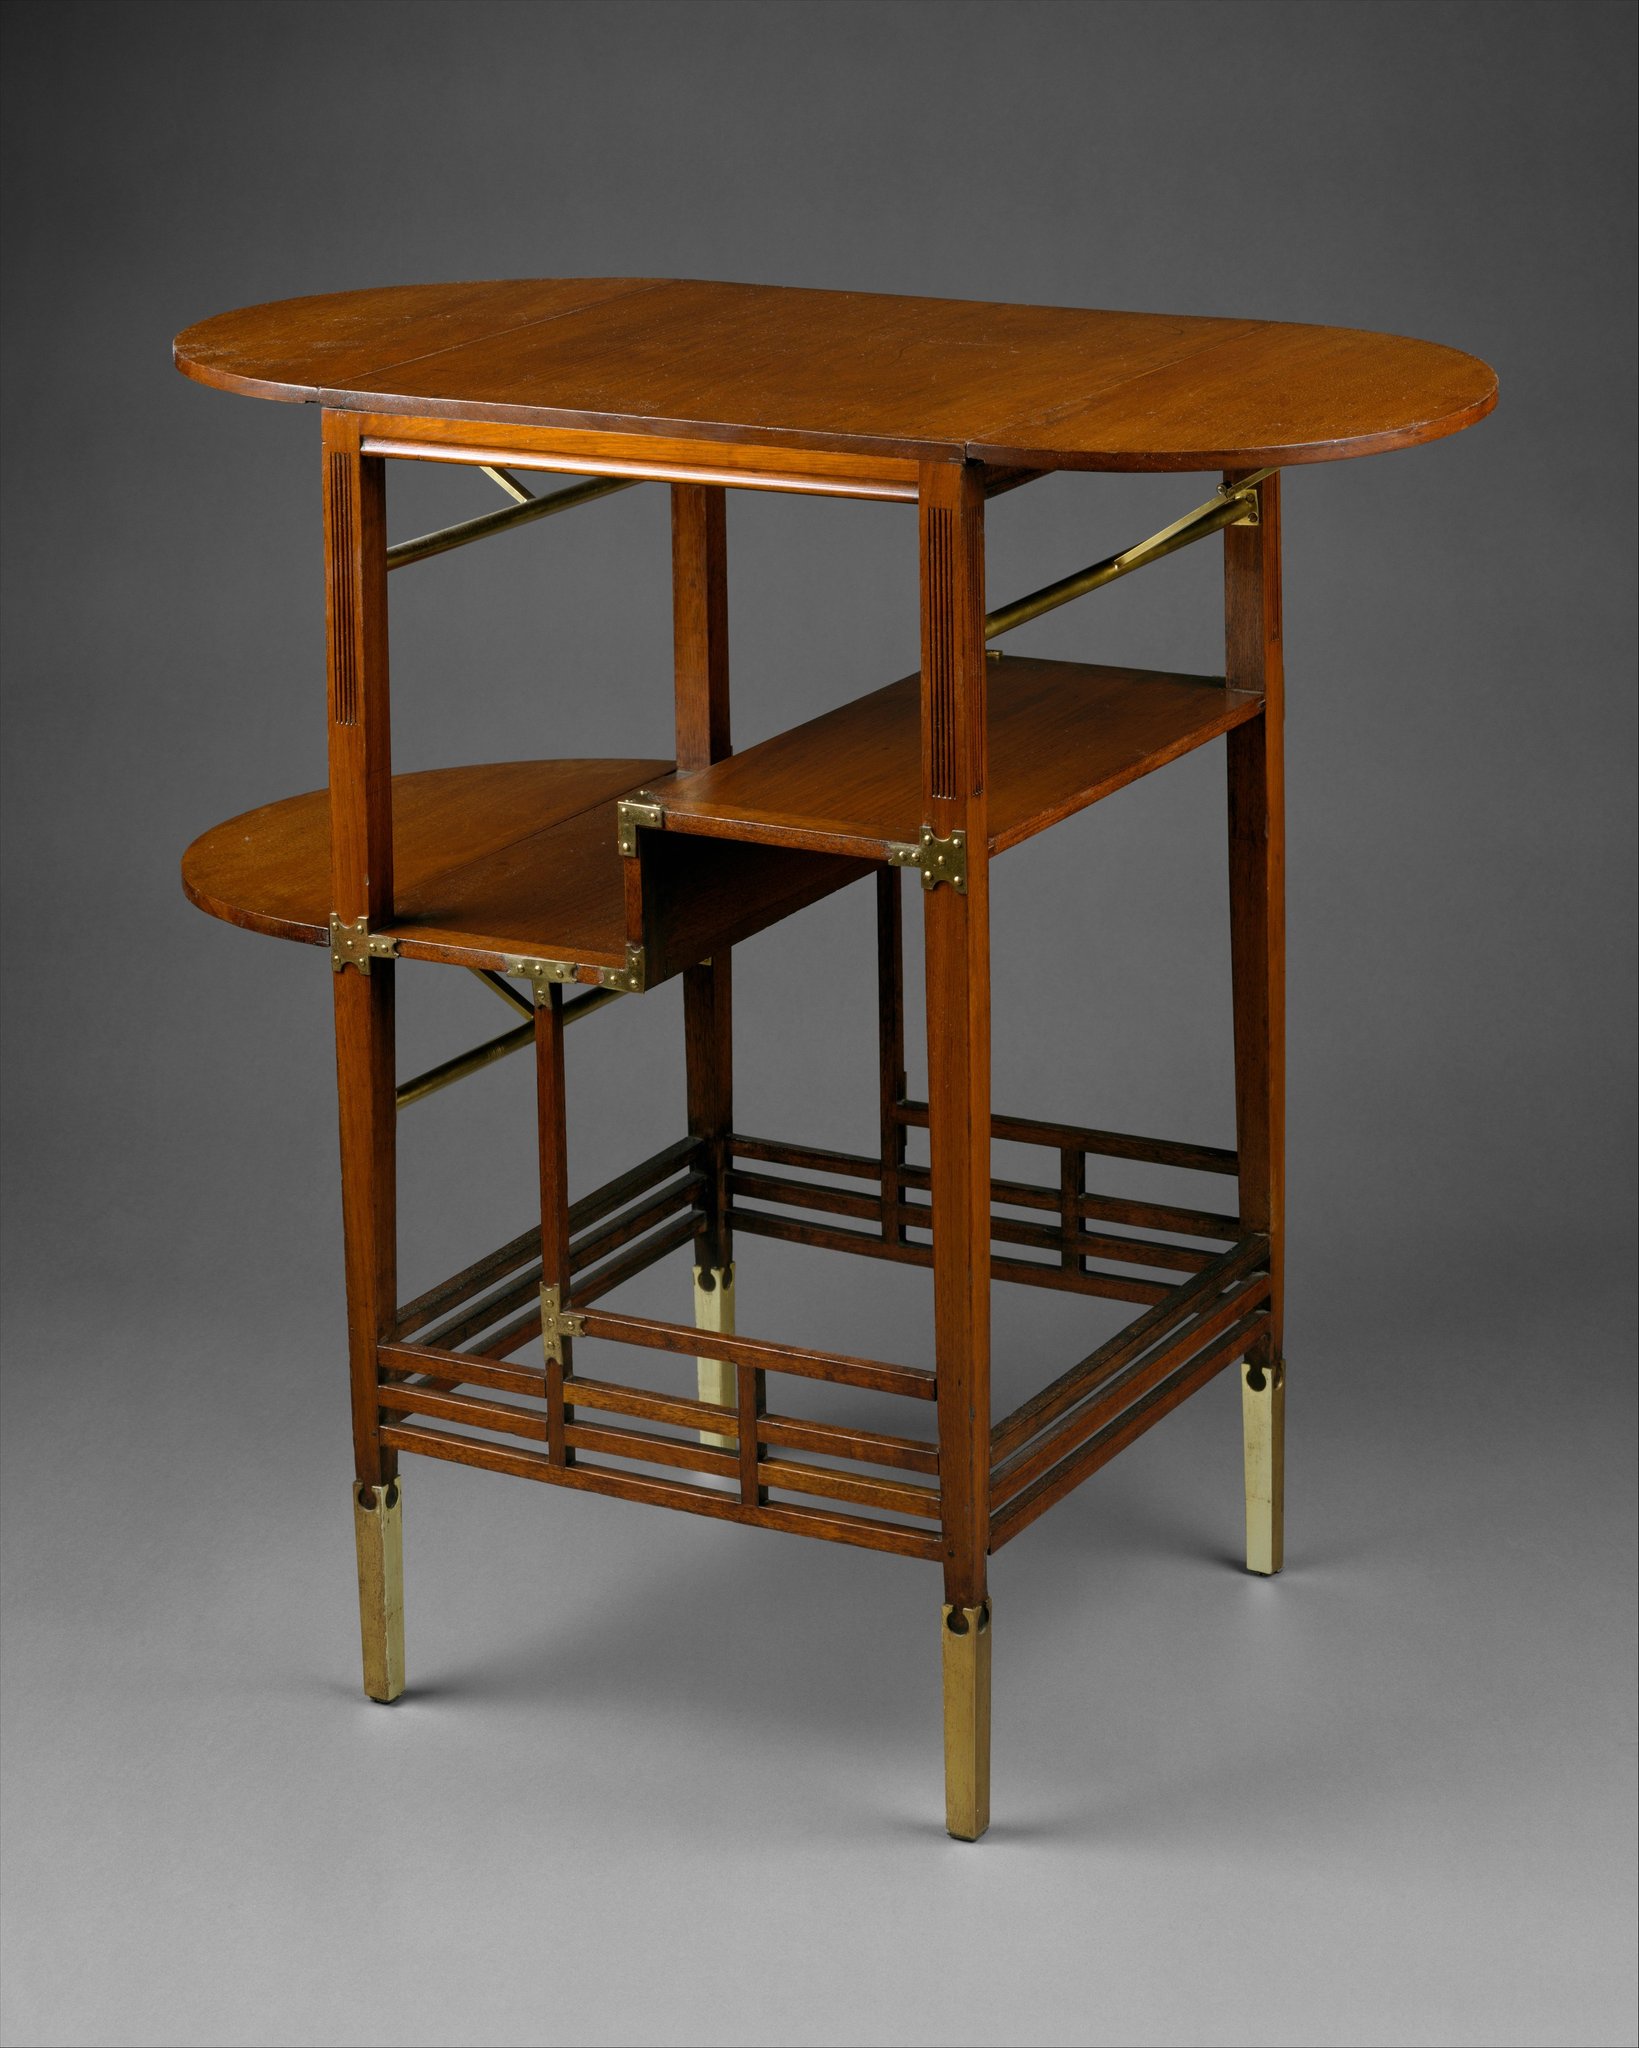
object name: side table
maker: edward william godwin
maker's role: designer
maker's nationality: british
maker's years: 1833-1886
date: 1872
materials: brass, gilt, wood